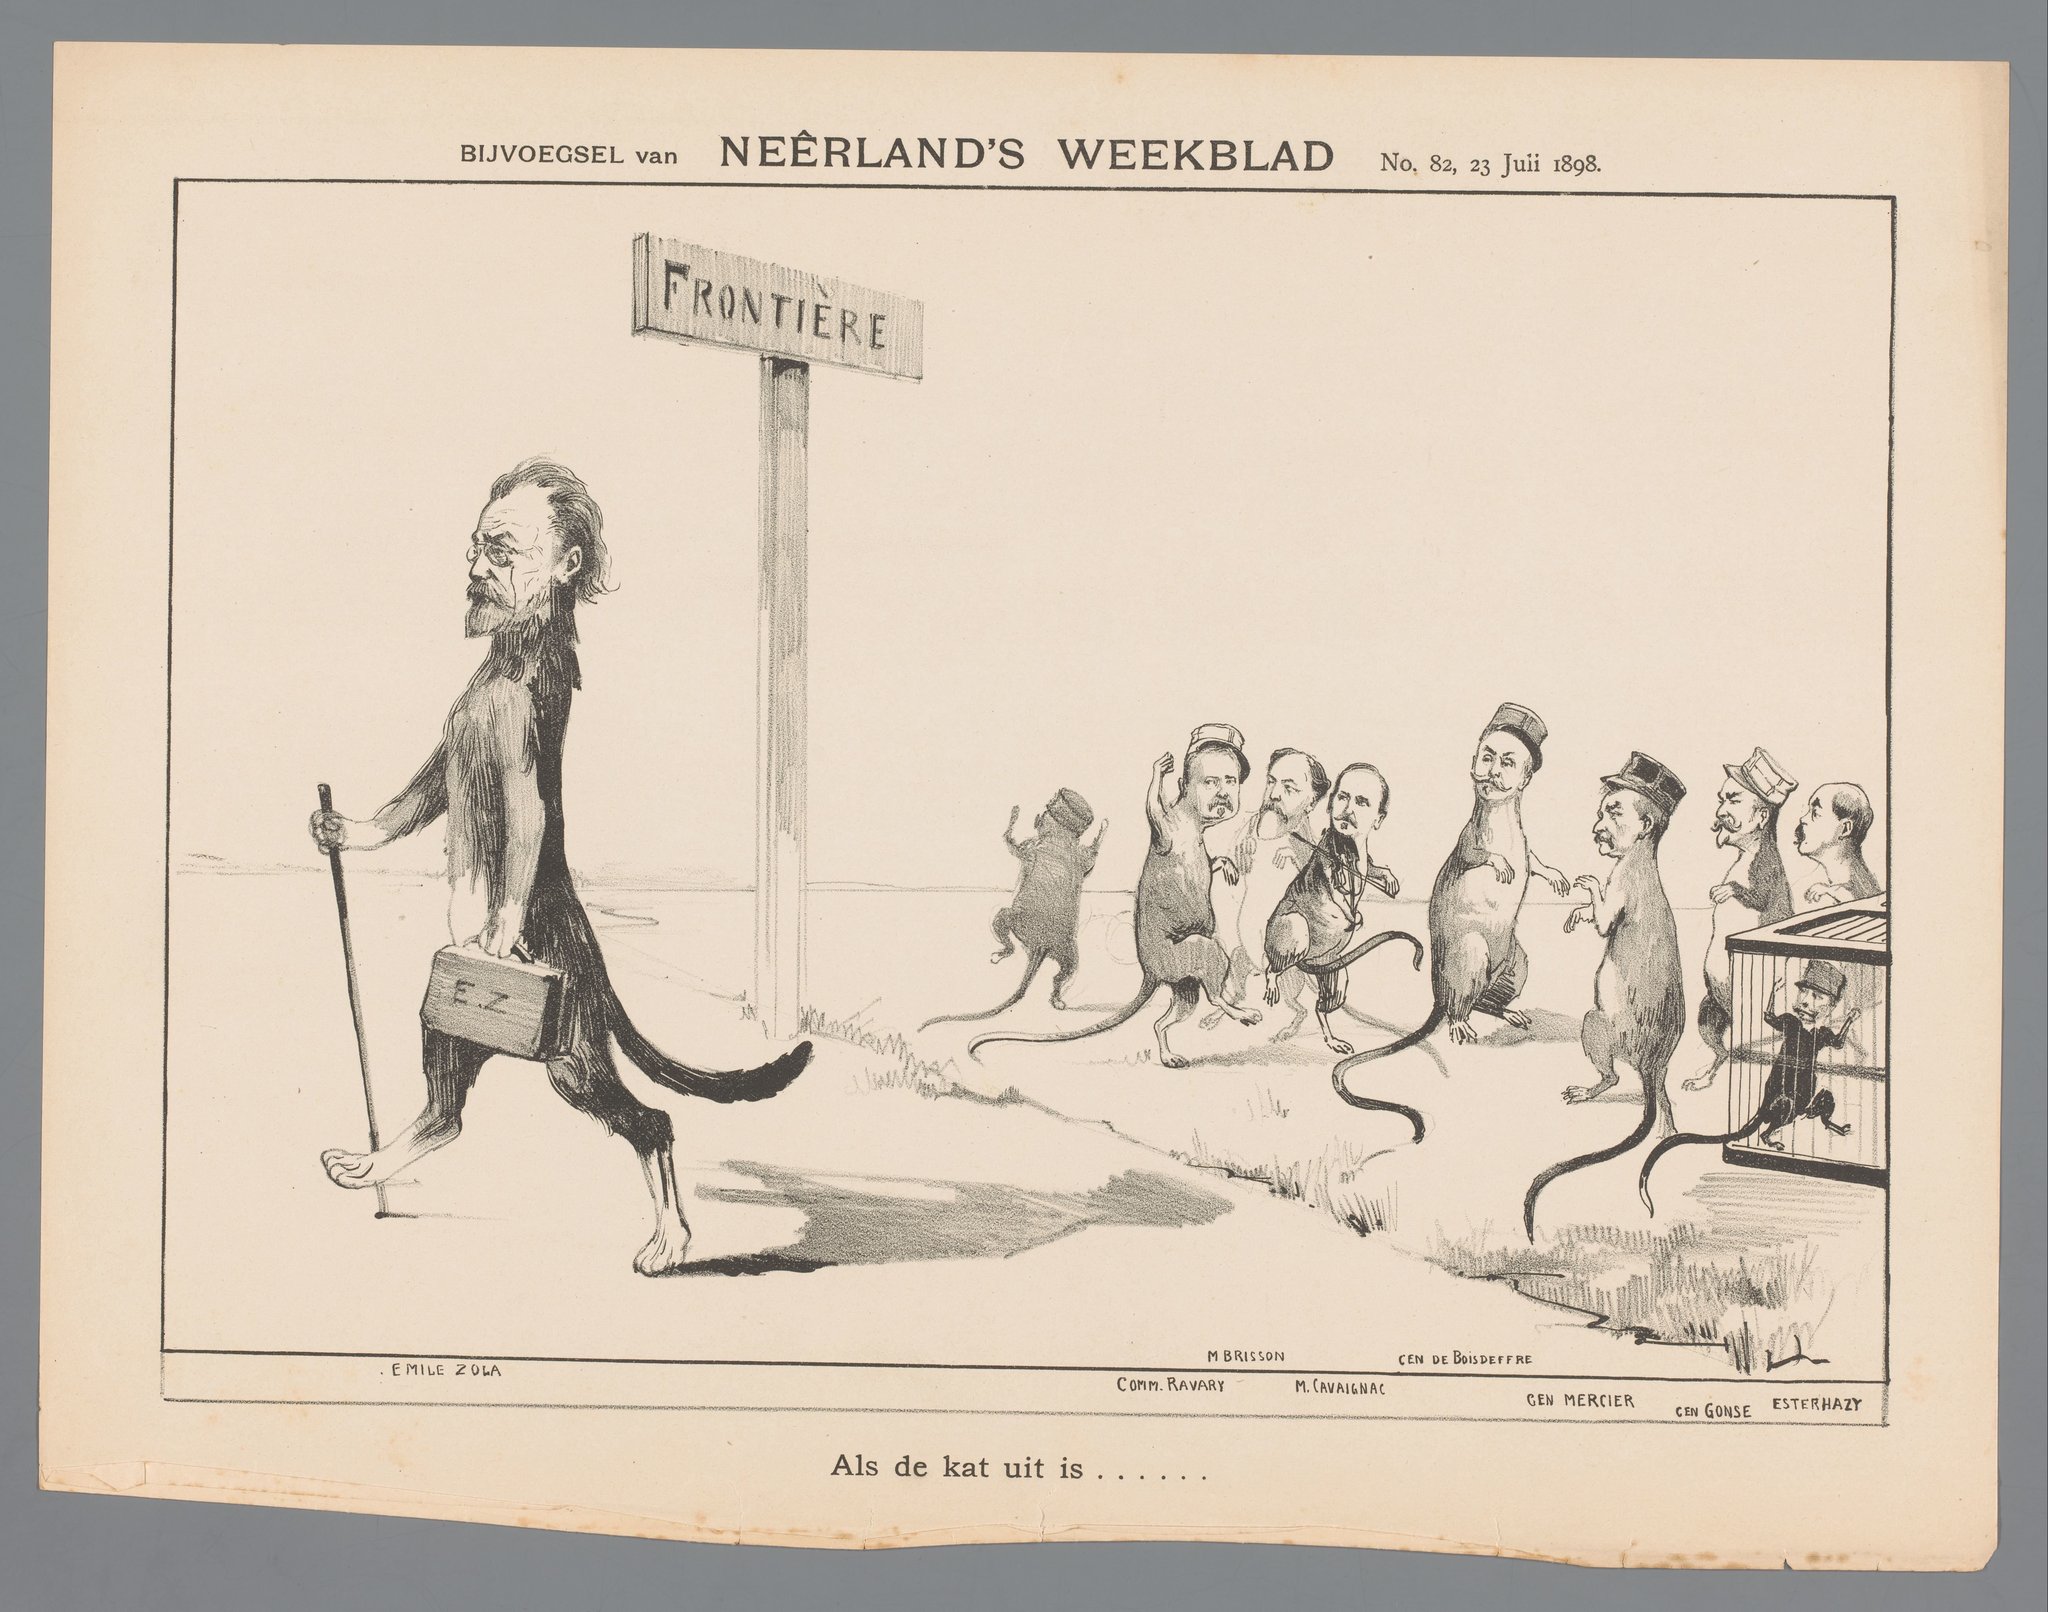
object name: cartoon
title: Als de kat uit is...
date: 1898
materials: paper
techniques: lithograph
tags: paris, emile zola, historical persons, cat and mouse, political caricatures and satires, france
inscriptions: date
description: Prent uit het bijvoegsel van: Neêrland’s Weekblad, nr. 82, 23 juli 1898.